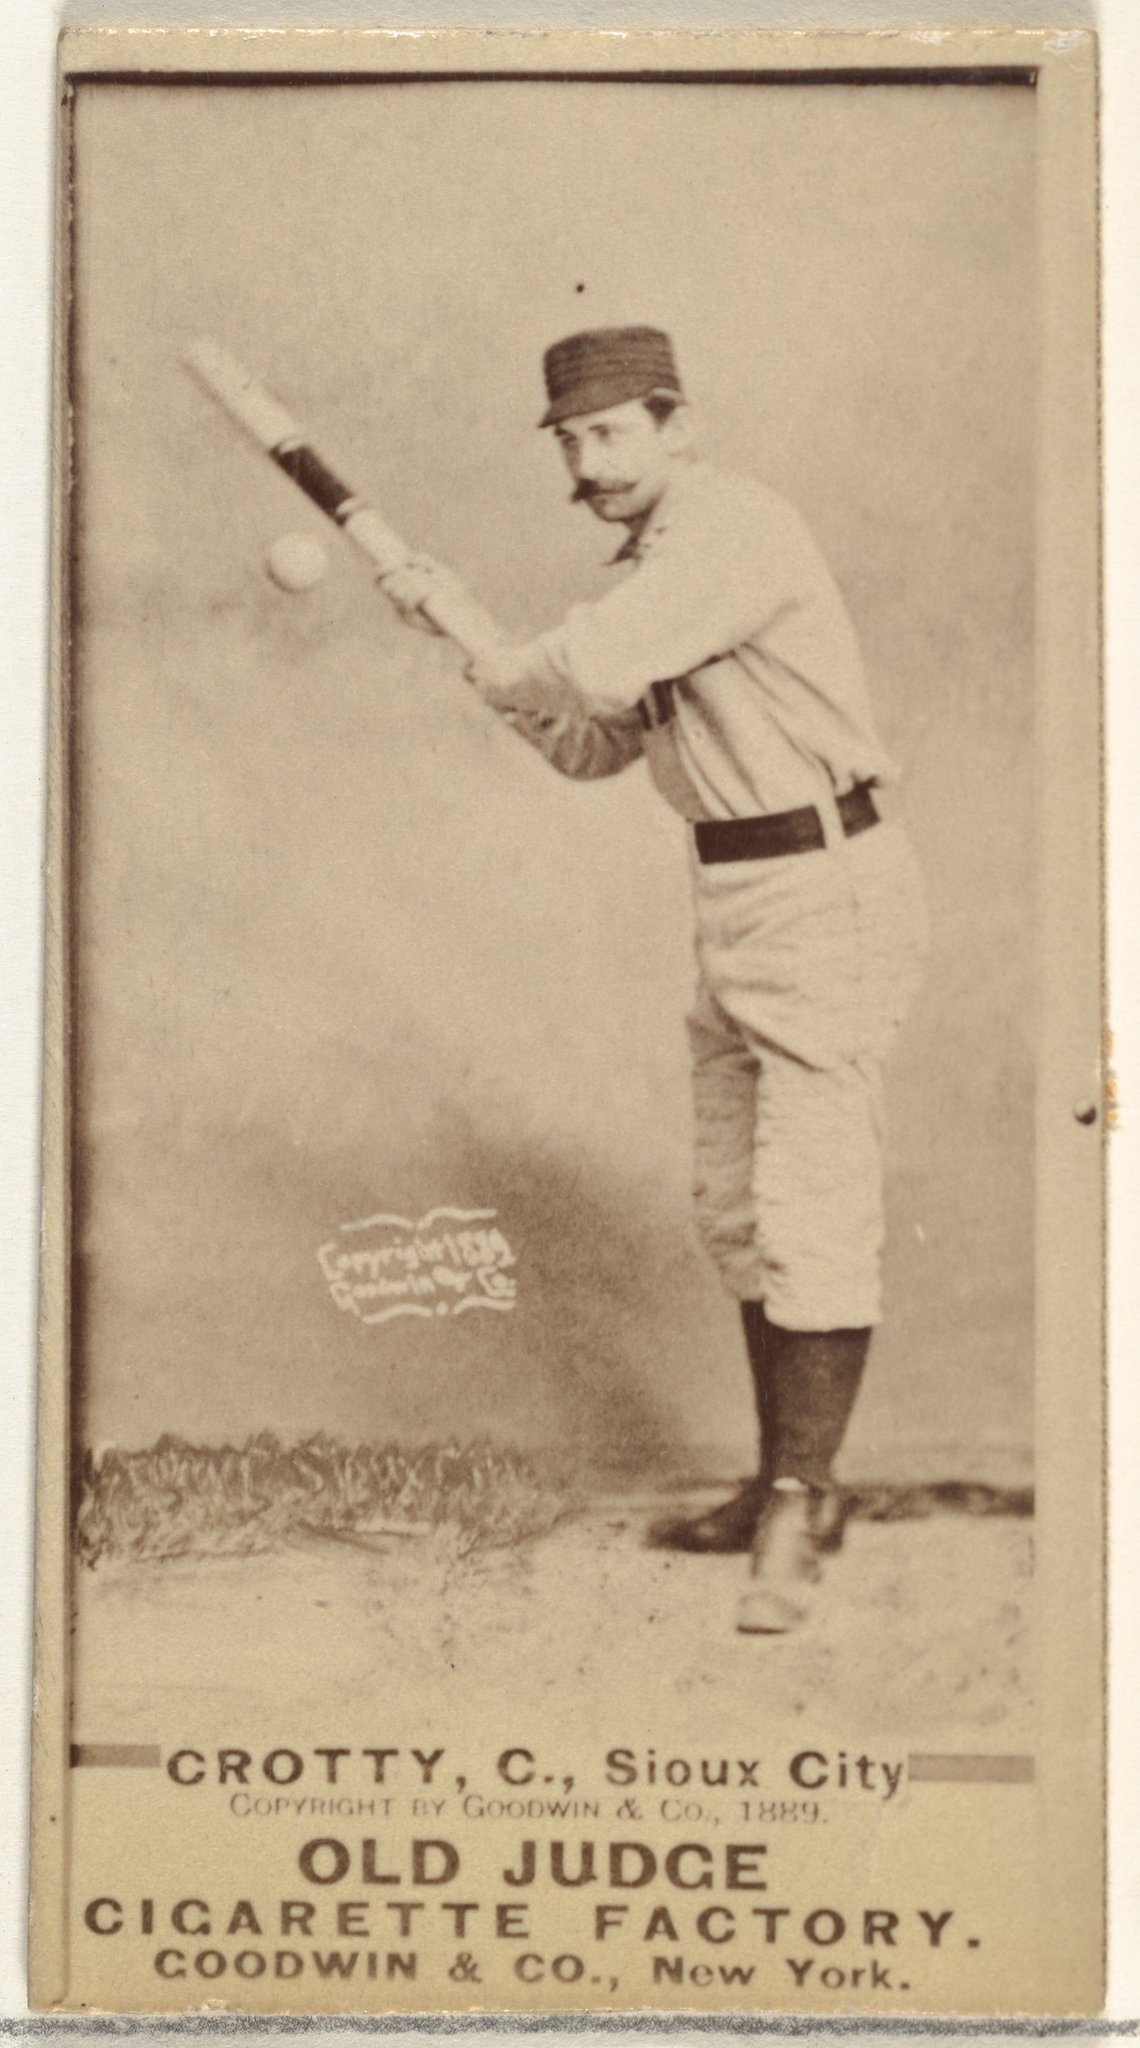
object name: baseball card, photograph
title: Joseph P. "Joe" Crotty, Catcher, Sioux City Corn Huskers, from the Old Judge series (N172) for Old Judge Cigarettes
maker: goodwin & company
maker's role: publisher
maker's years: 1850-1950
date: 1889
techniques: albumen silver print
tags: men,portraits,baseball,athletes